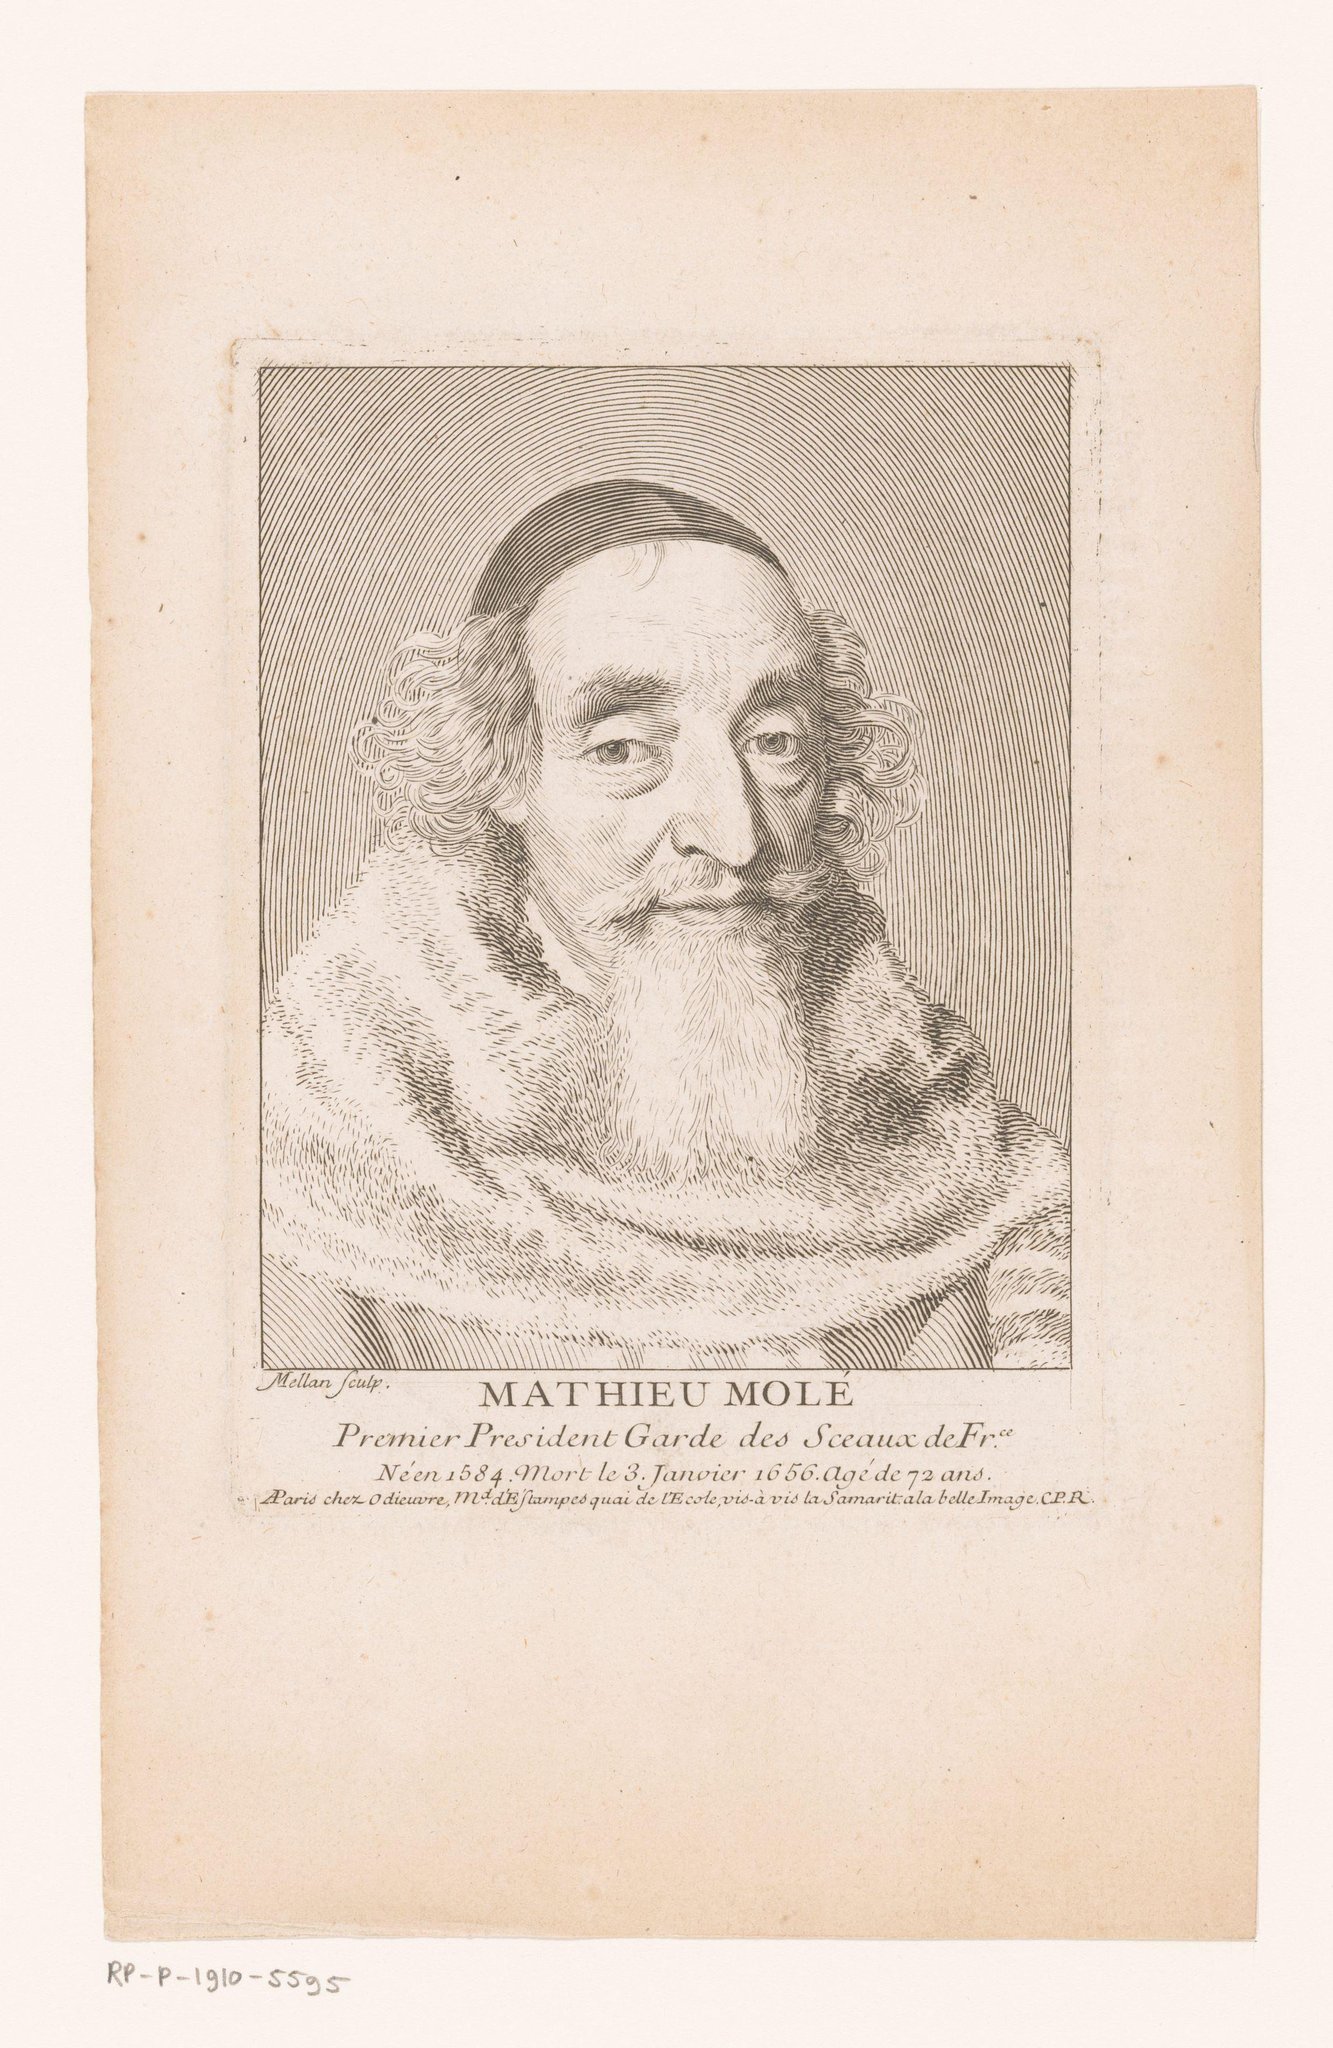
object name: book illustration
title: Portret van Mathieu Molé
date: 1634-1688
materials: paper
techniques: engraving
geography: france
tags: paris, mathieu molé, historical persons, armorial bearing, heraldry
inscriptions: collector's mark: Lugt 2228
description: Prent uit: Dreux du Radier, Jean-François. L'Europe illustré, contenant l'histoire abregée des souverains, des princes, des prélats, des ministres, (...) en Europe: dans le XVe. siècle compris, jusqu'à présent. Parijs: Michel Odieuvre en Jean-Luc Nyon, 1755-1765. De voorbereidende tekening bevindt zich in de collectie van de Hermitage te Sint-Petersburg, inv.nr. 4617.